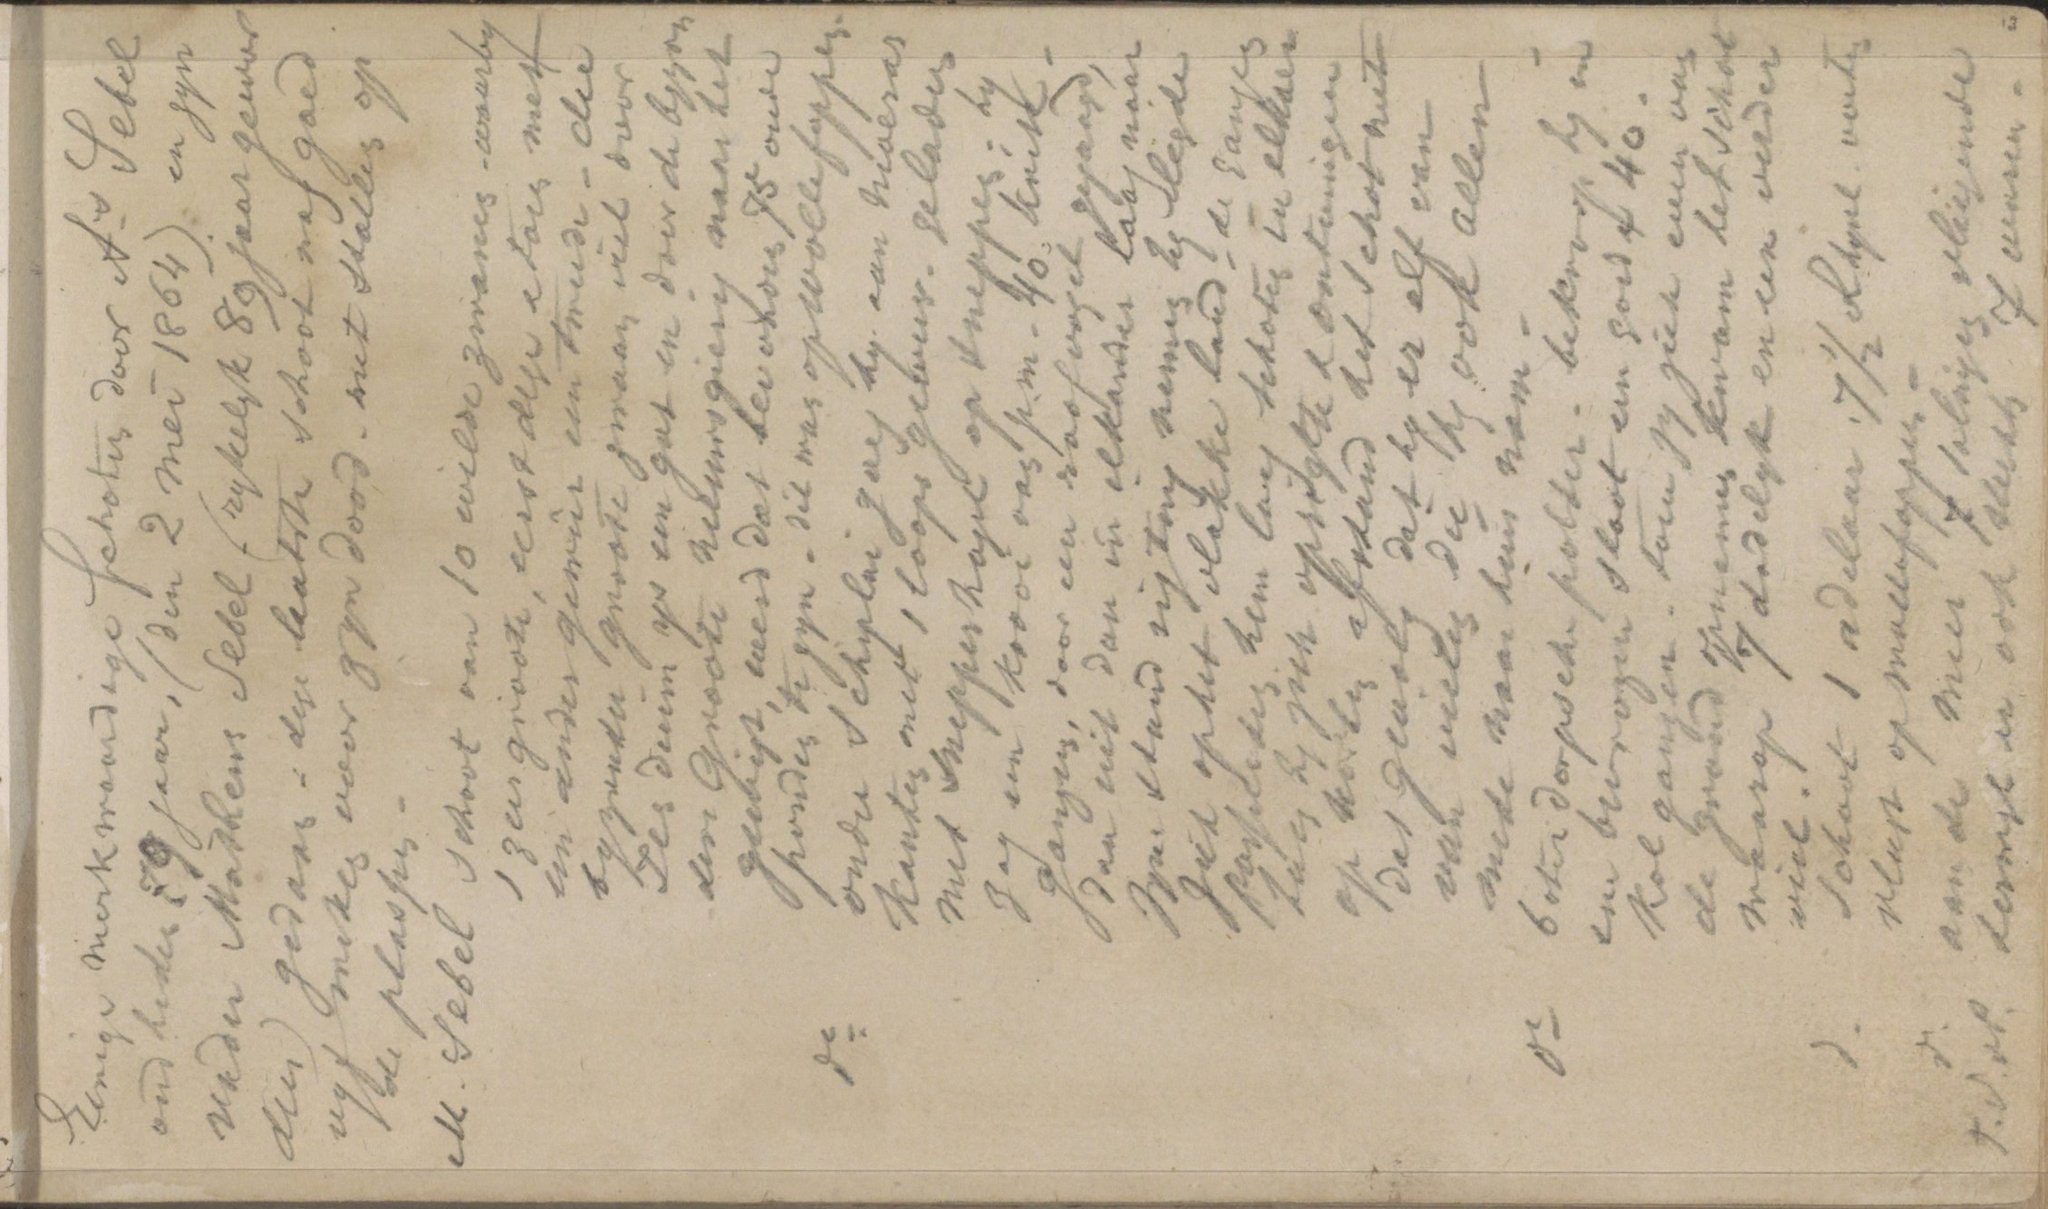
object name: sketchbook leaf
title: Notities over jachtopziener Ad Sebel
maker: johannes tavenraat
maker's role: draughtsman, painter, print maker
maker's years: 1809-1881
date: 1864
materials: paper, pencil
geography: capelle aan den ijssel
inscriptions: date and inscription: ‘[...]’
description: Sebel was jachtopziener van het jachthuis Sneppenschrik bij Capelle aan den IJssel.